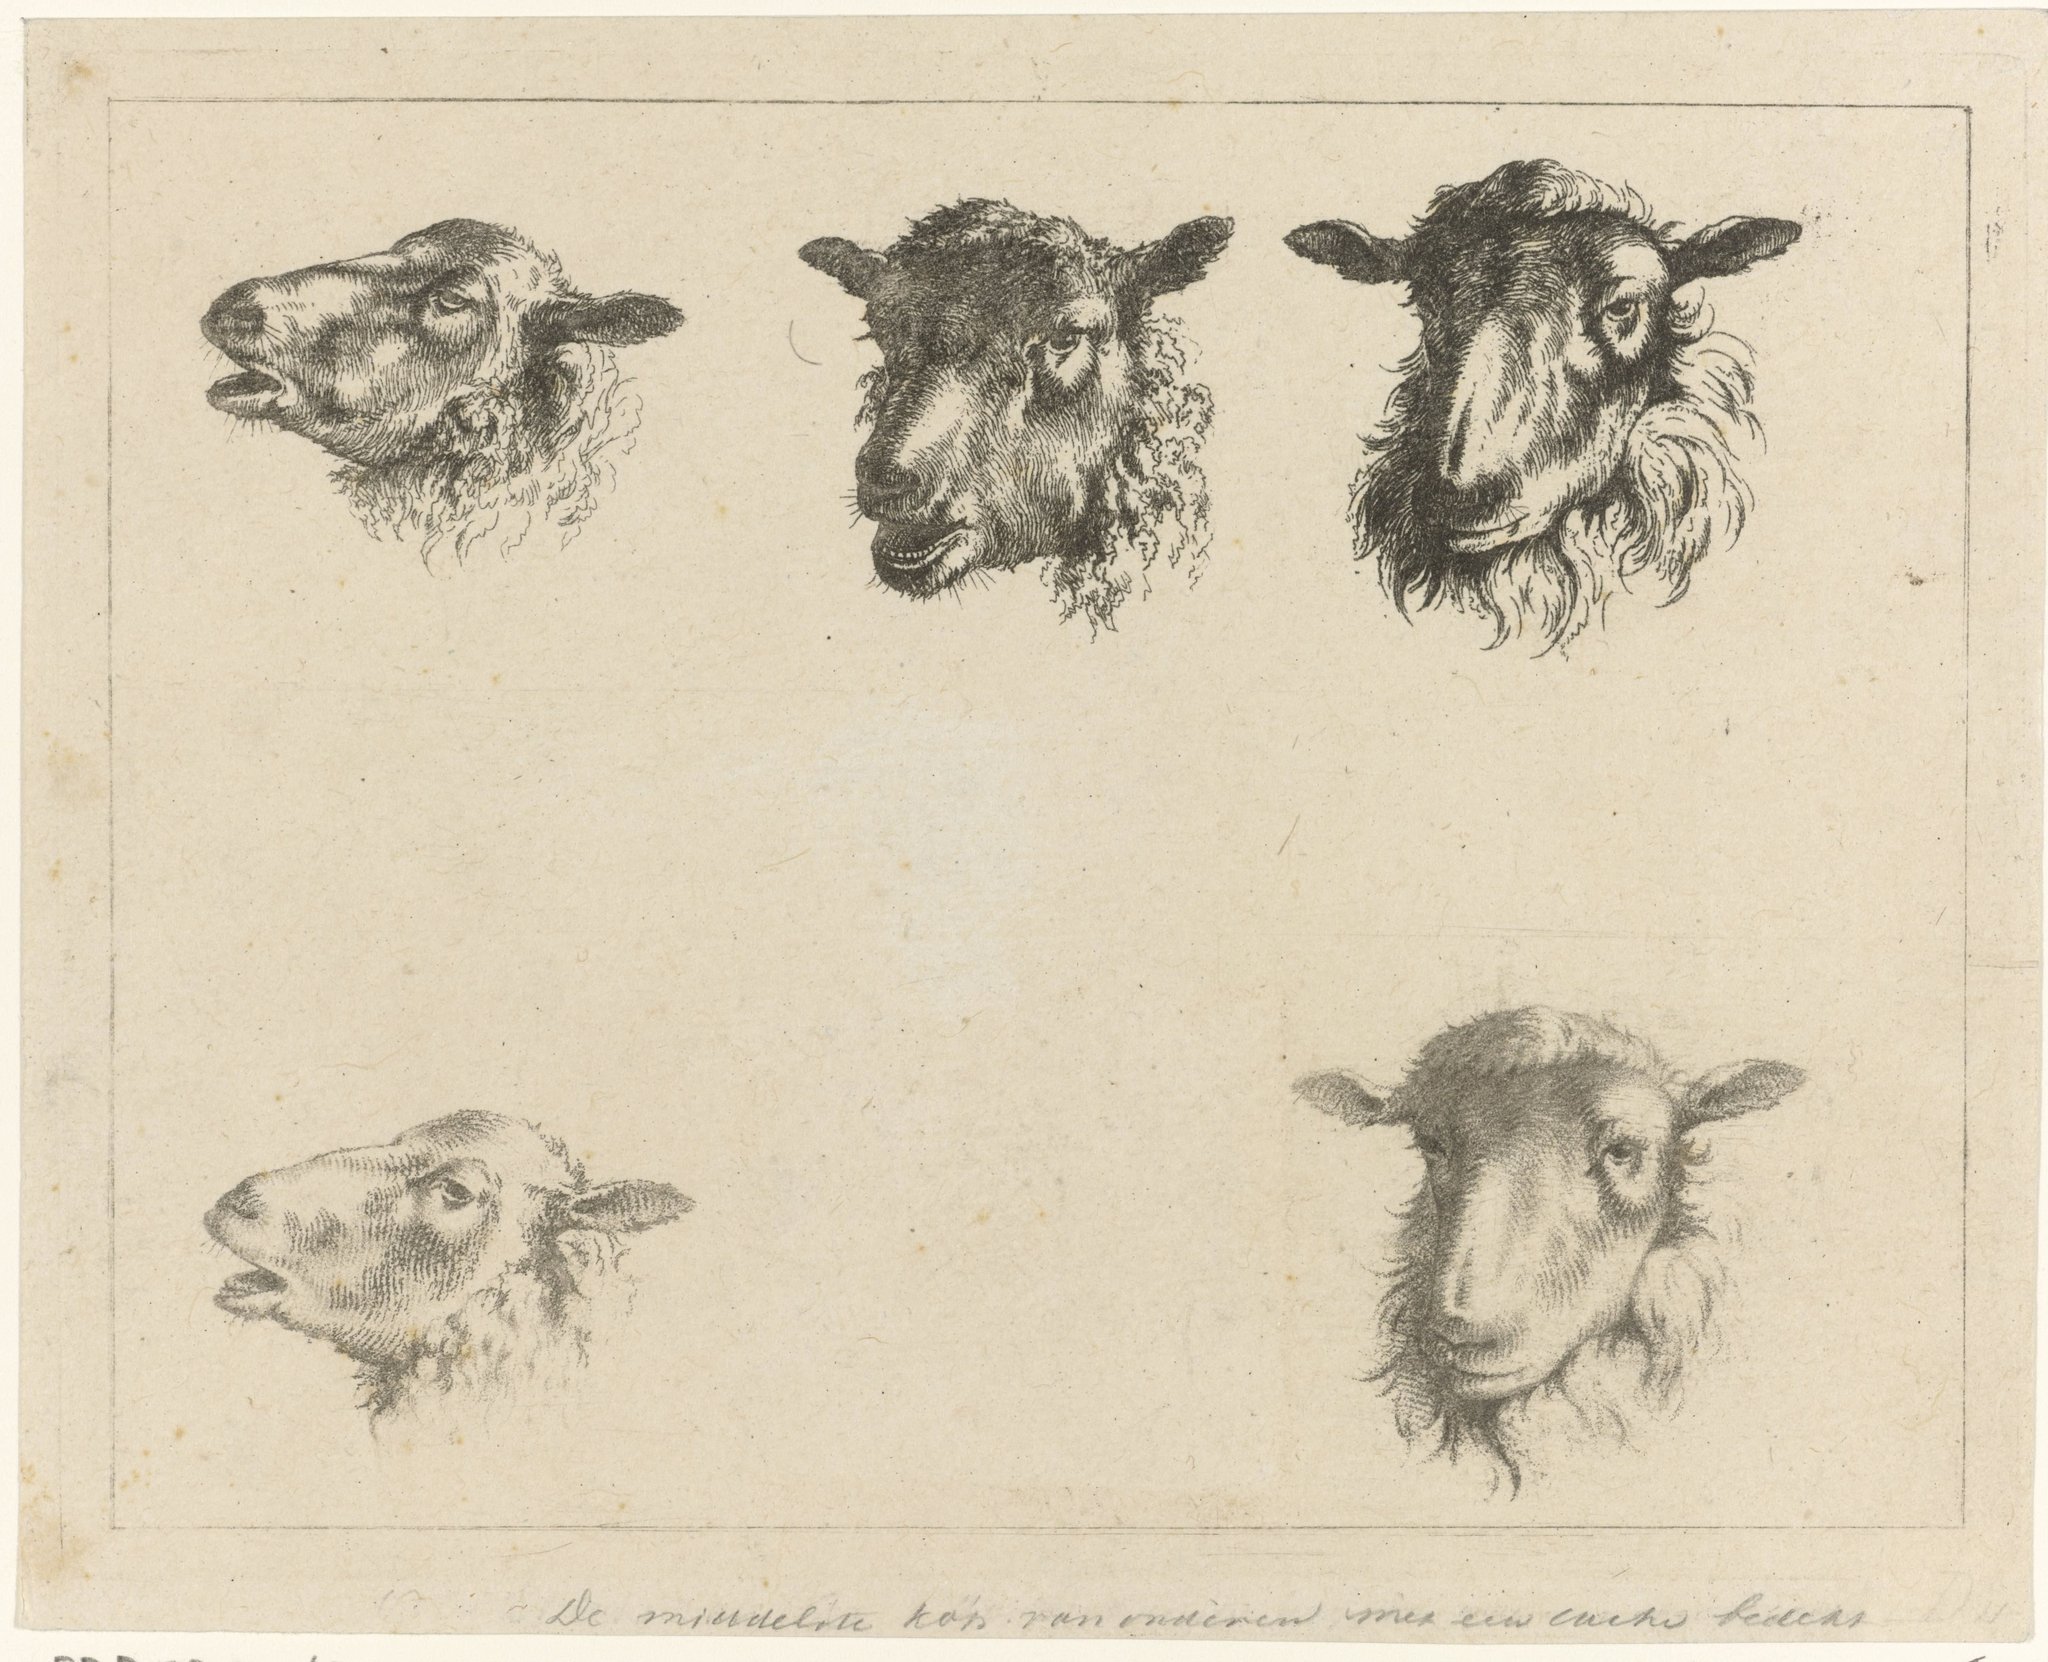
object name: print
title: Studieblad met vijf schapenkoppen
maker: johannes janson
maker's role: draughtsman, painter, print maker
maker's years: 1729-1784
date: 1761-1784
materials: paper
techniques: etching, soft ground etching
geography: leiden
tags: sheep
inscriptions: collector's mark: Lugt 240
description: De middelste kop van onderen, van de zesde schapenkop, is met een cache bedekt.